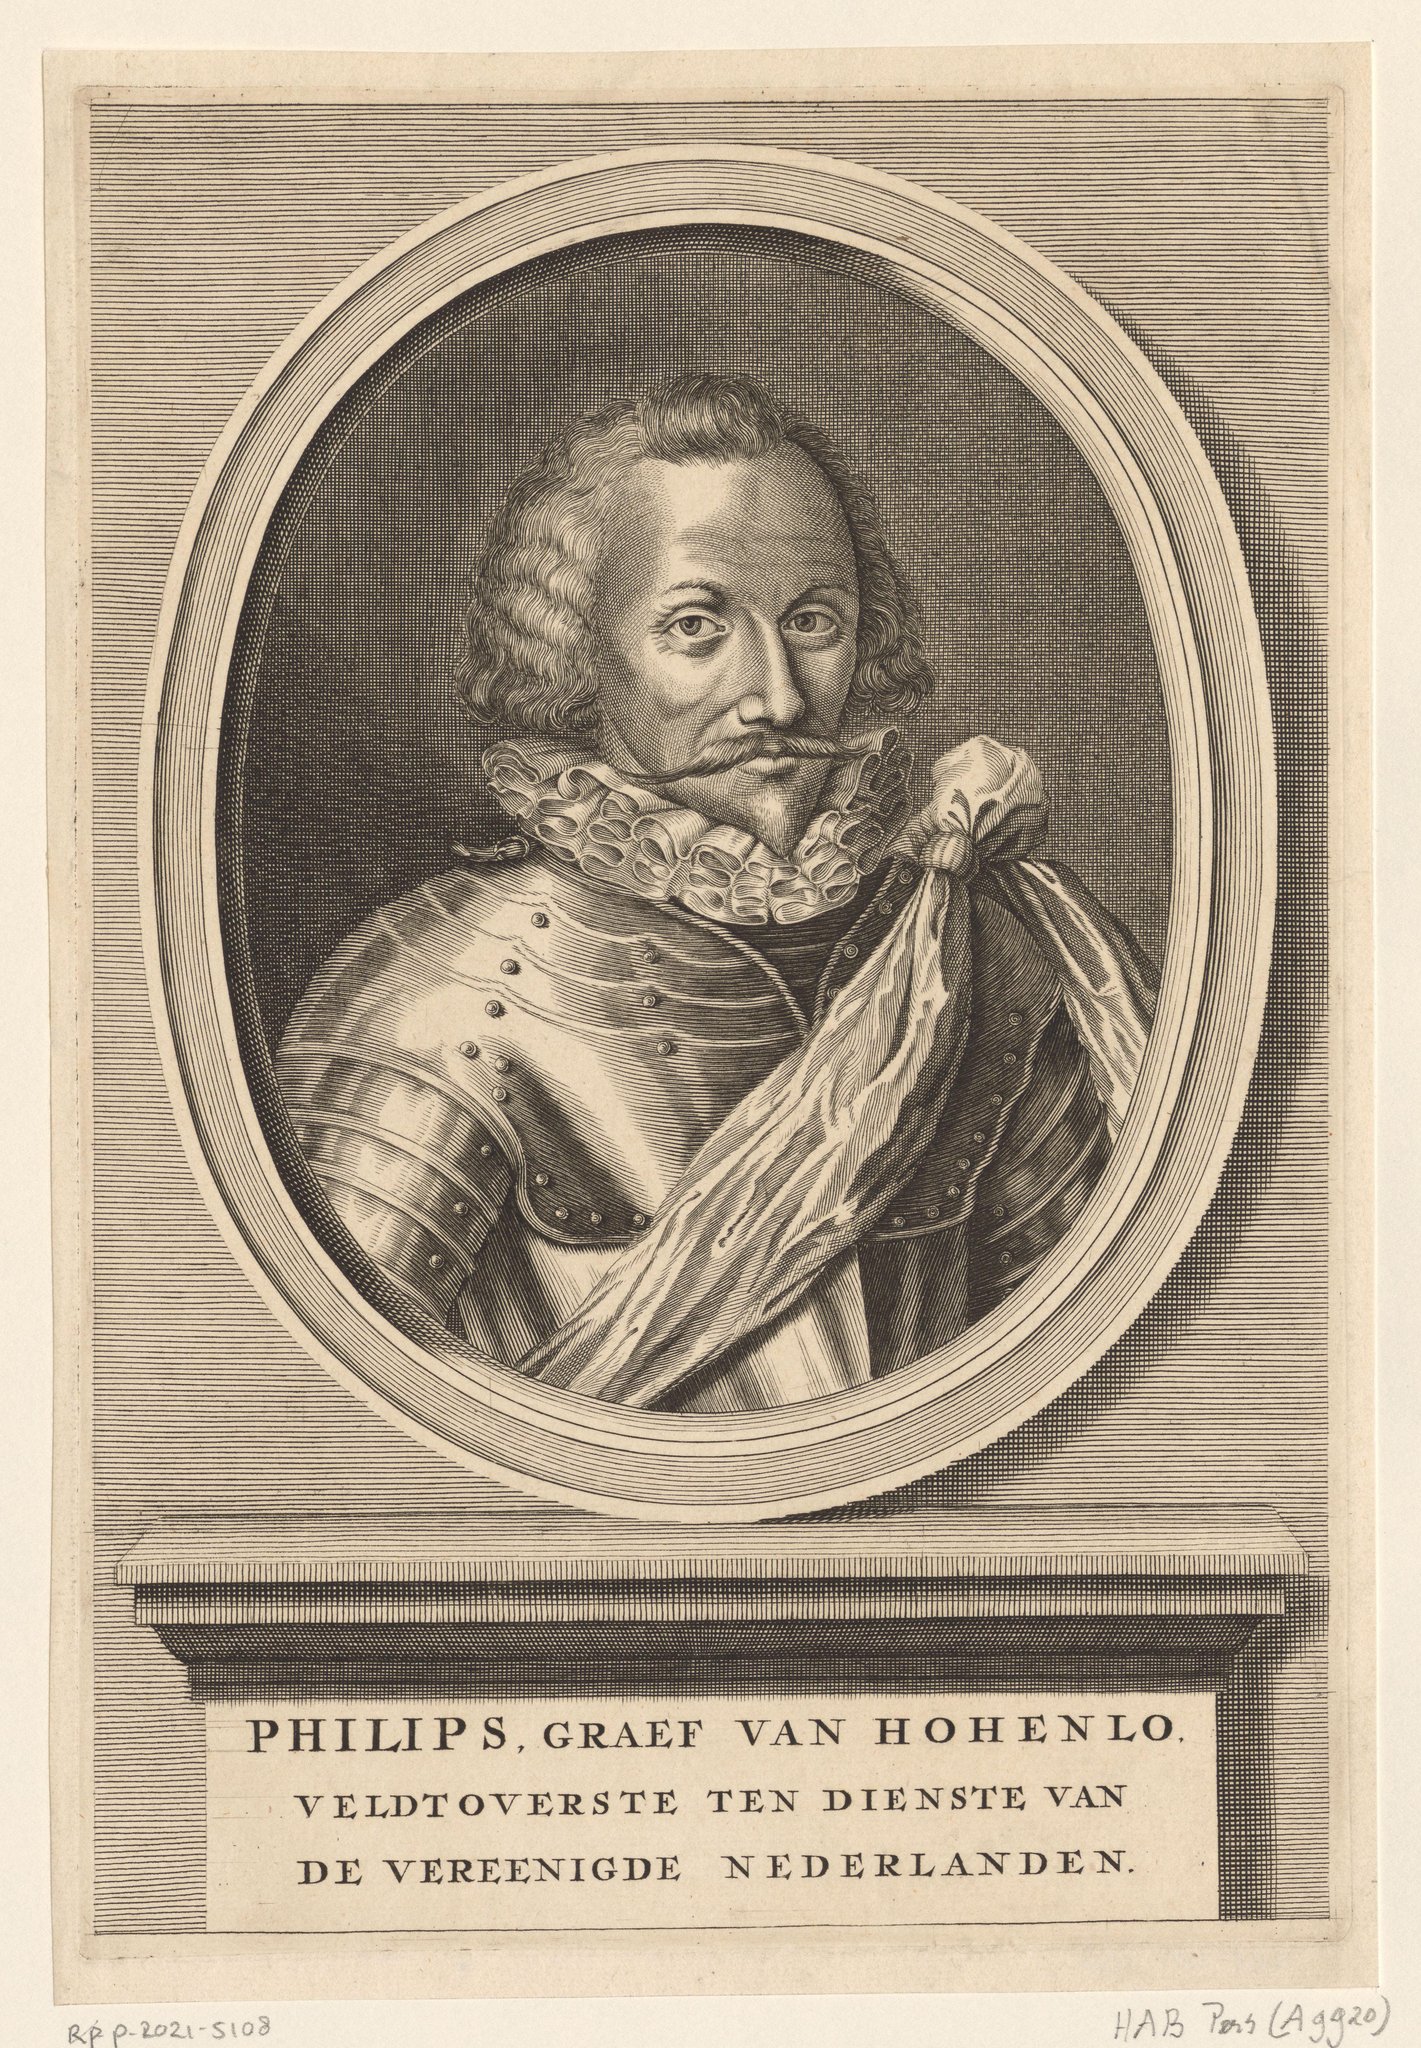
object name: print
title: Portret van Filips, graaf van Hohenlohe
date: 1703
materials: paper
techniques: engraving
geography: leiden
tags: moustache, adult man, historical persons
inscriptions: collector's mark: Lugt 2228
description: Prent uit: Hooft, Pieter Corneliszoon. Nederlandsche historien, seedert de ooverdraght der heerschappye van kaizar Karel den Vyfden op koning Philips zynen zoon, tot het einde der landtvooghdye des graven van Leicester. 4e druk. 2 dln. Amsterdam: Henricus Wetstein en Pieter Sceperus, Leiden: Daniel van den Dalen en Utrecht: Willem van de Water, 1703, dl. 2.